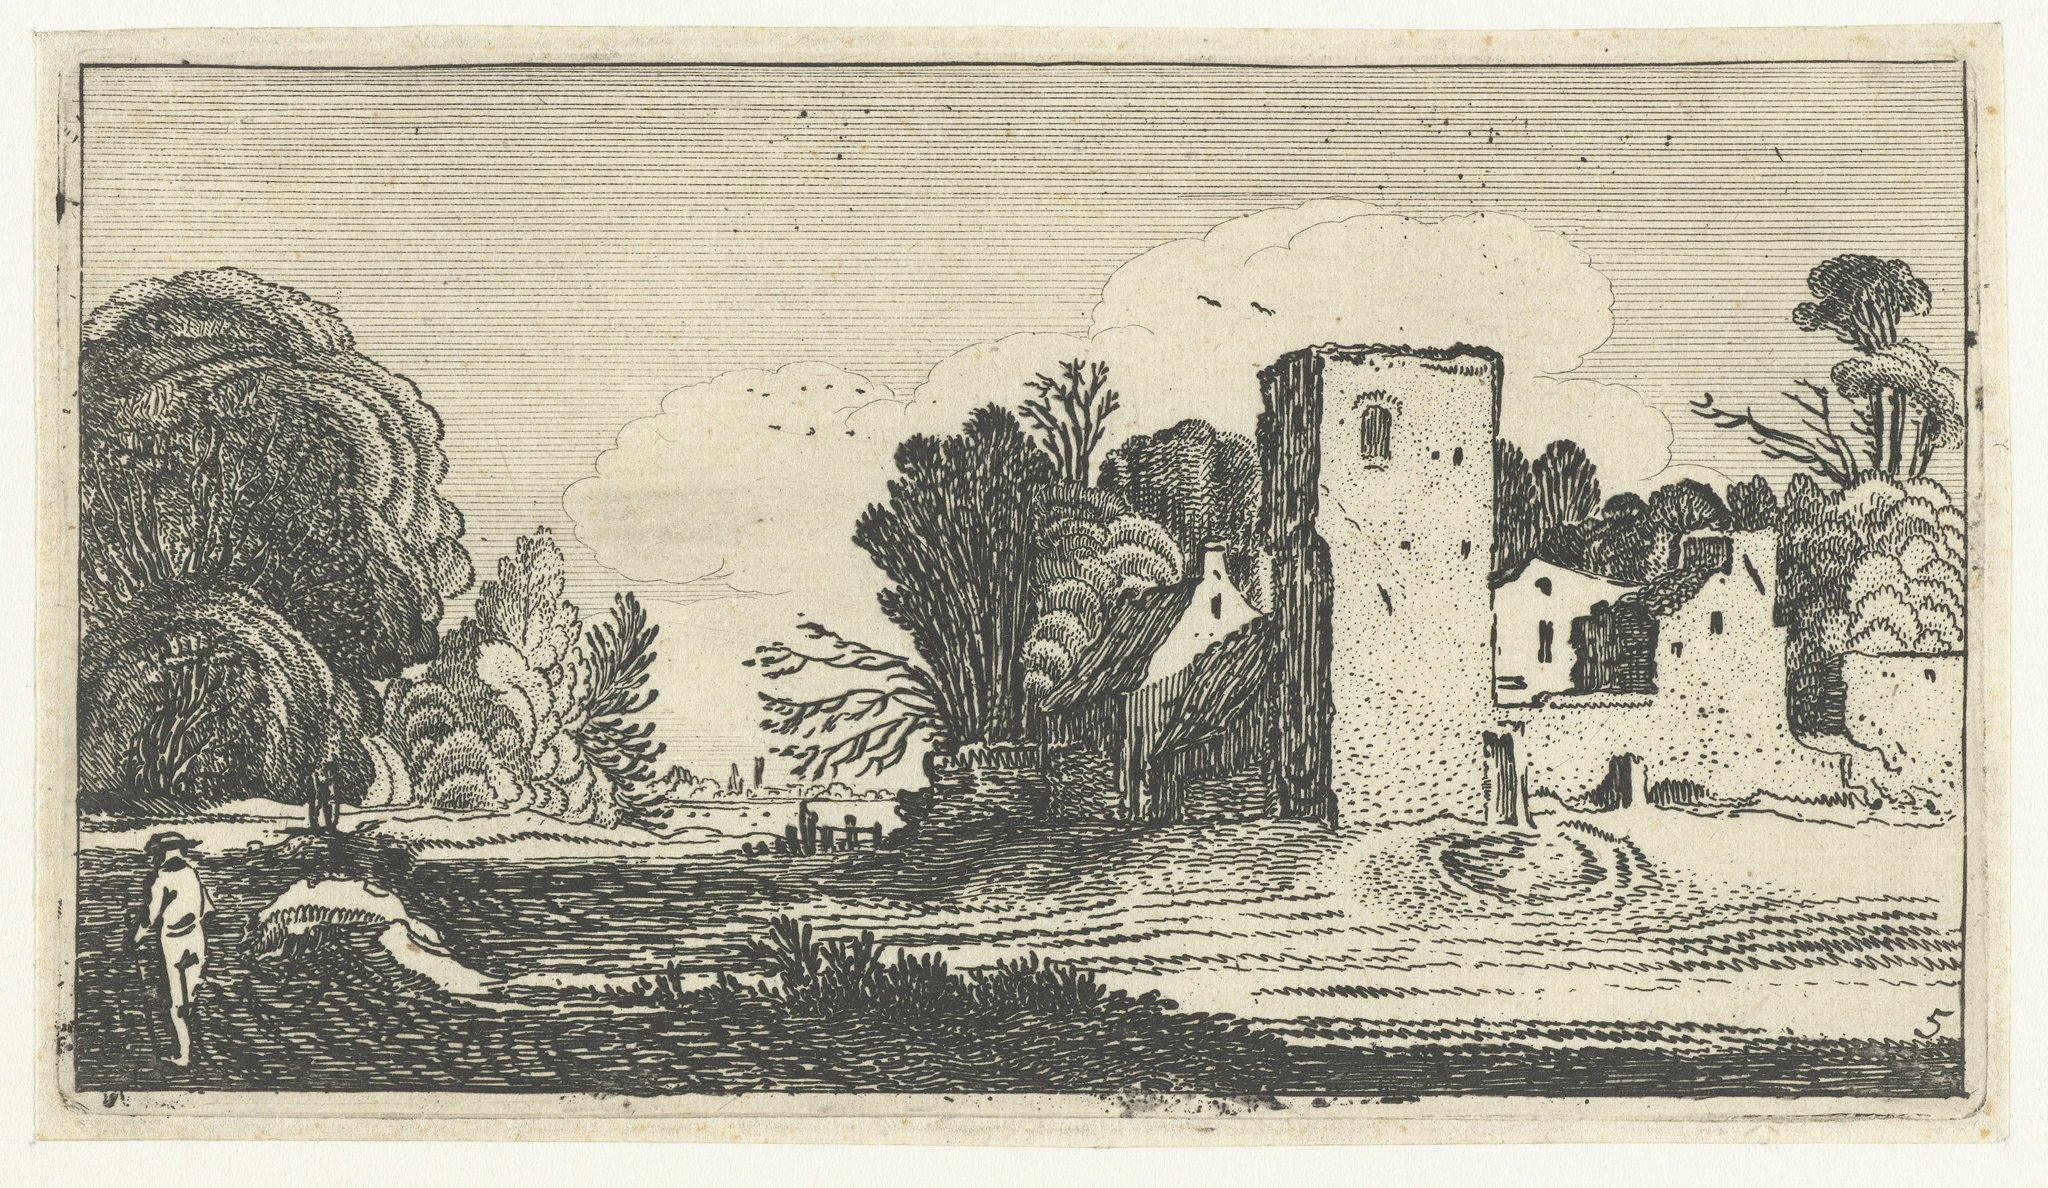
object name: print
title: Landschap met vierkante toren bij huizen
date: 1610-1650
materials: paper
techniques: etching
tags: landscape with tower or castle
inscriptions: collector's mark: Lugt 2228a